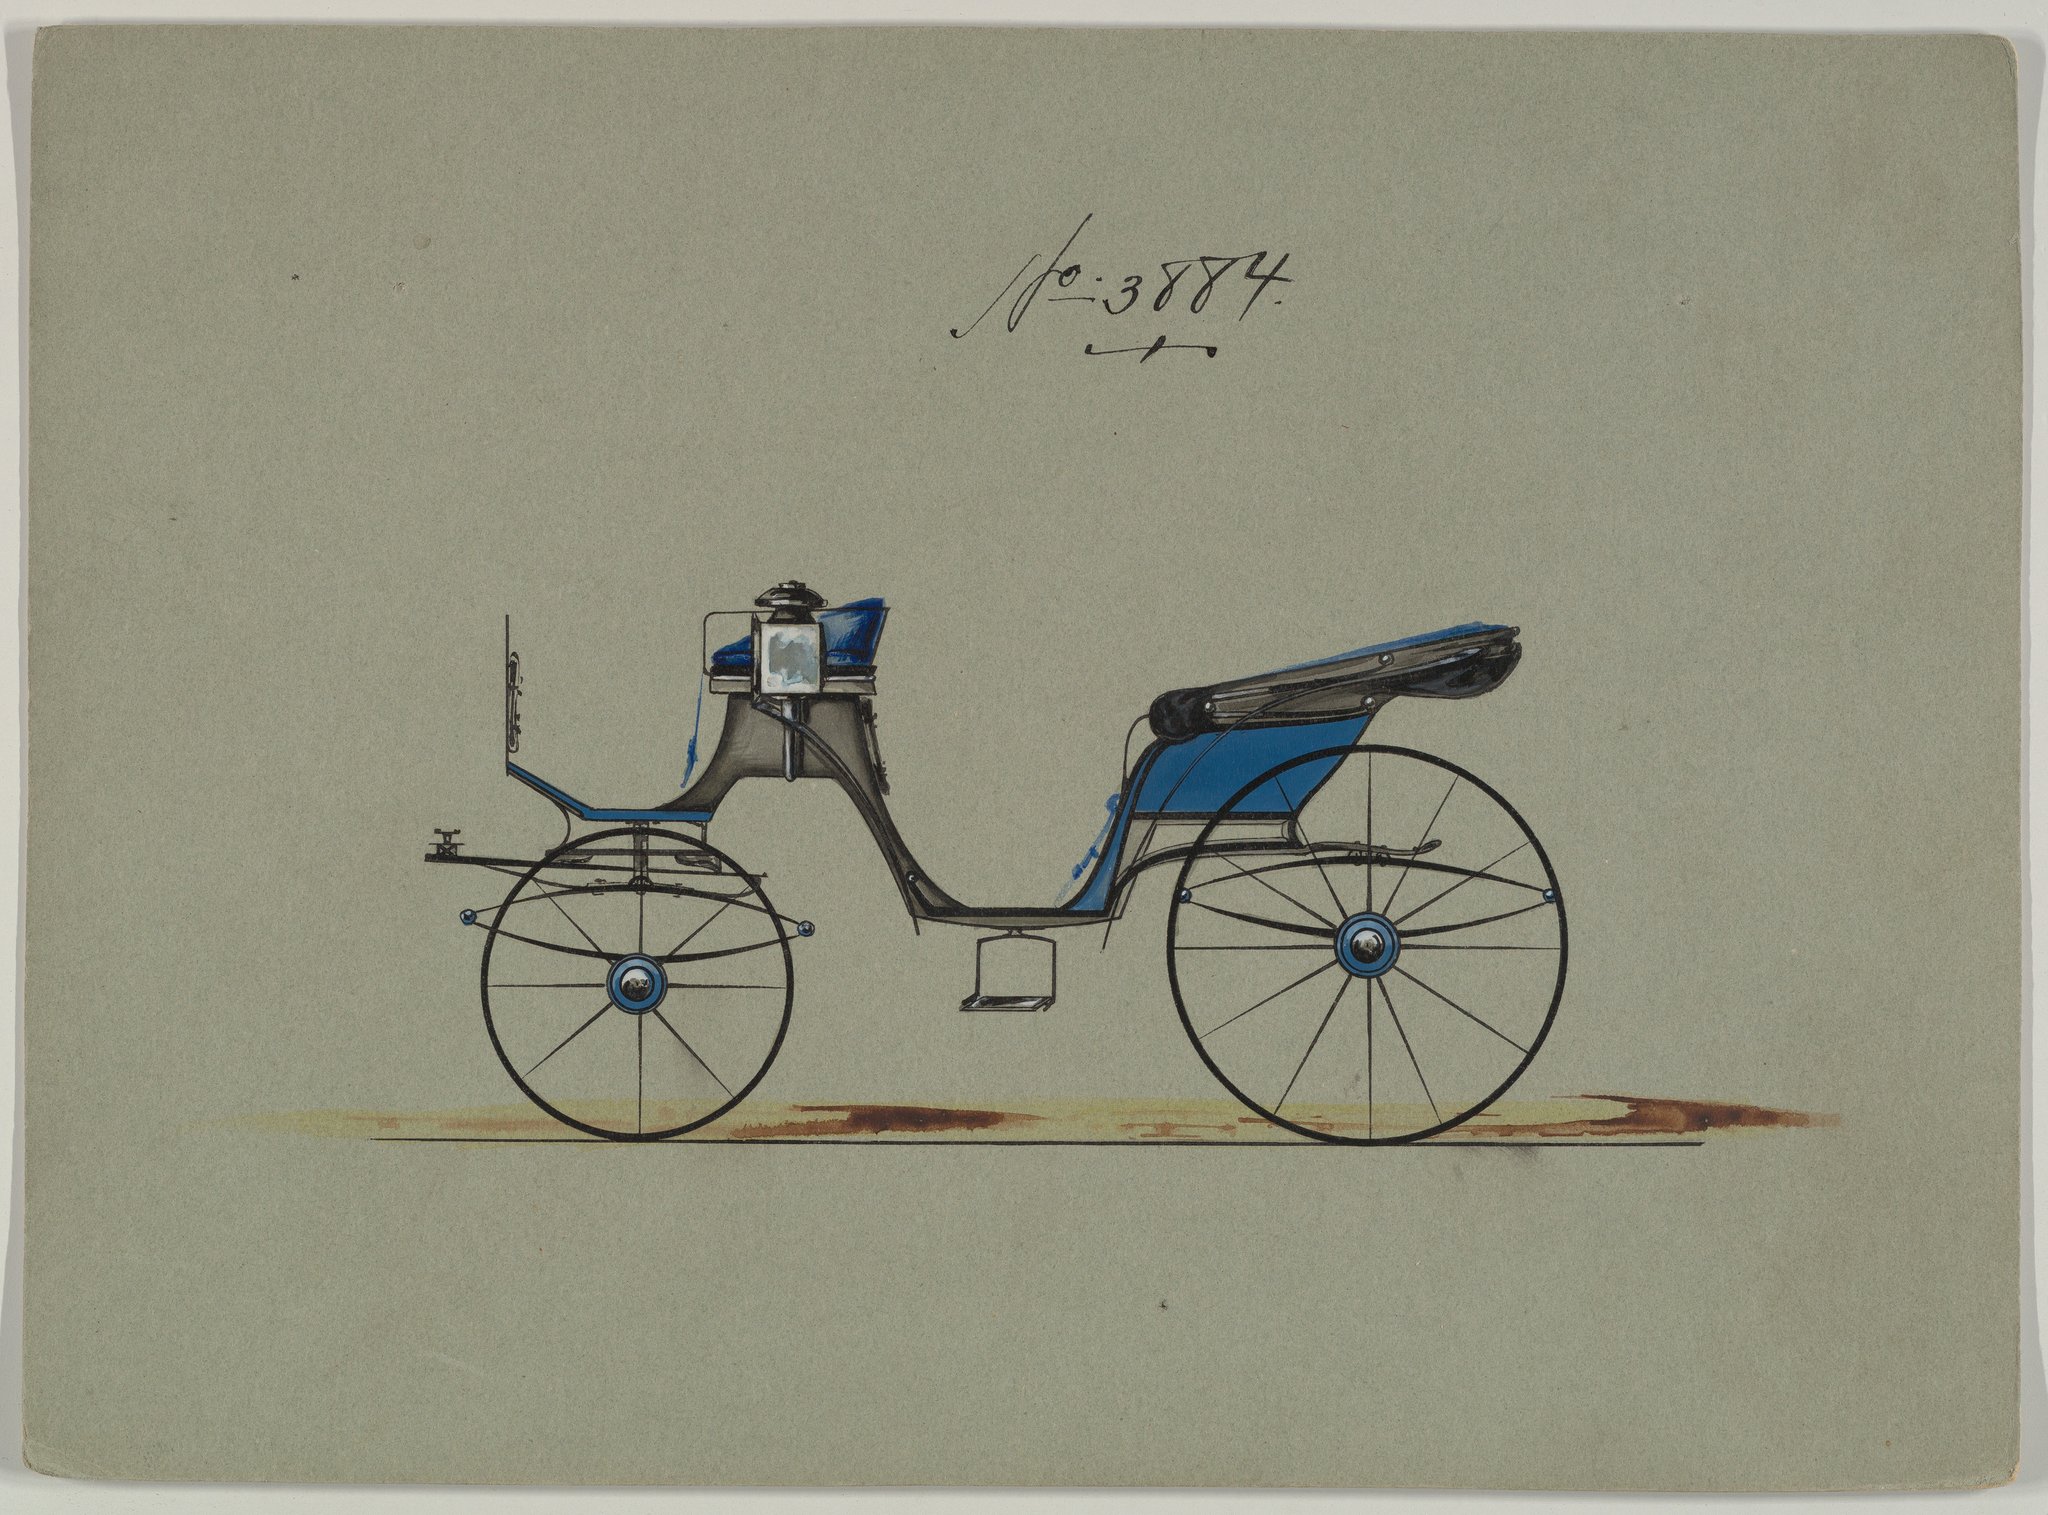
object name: drawing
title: Design for Cabriolet or Victoria, no. 3884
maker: brewster & co.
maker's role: manufacturer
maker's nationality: american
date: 1884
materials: gouache, gum arabic, ink, watercolor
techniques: pen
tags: carriages